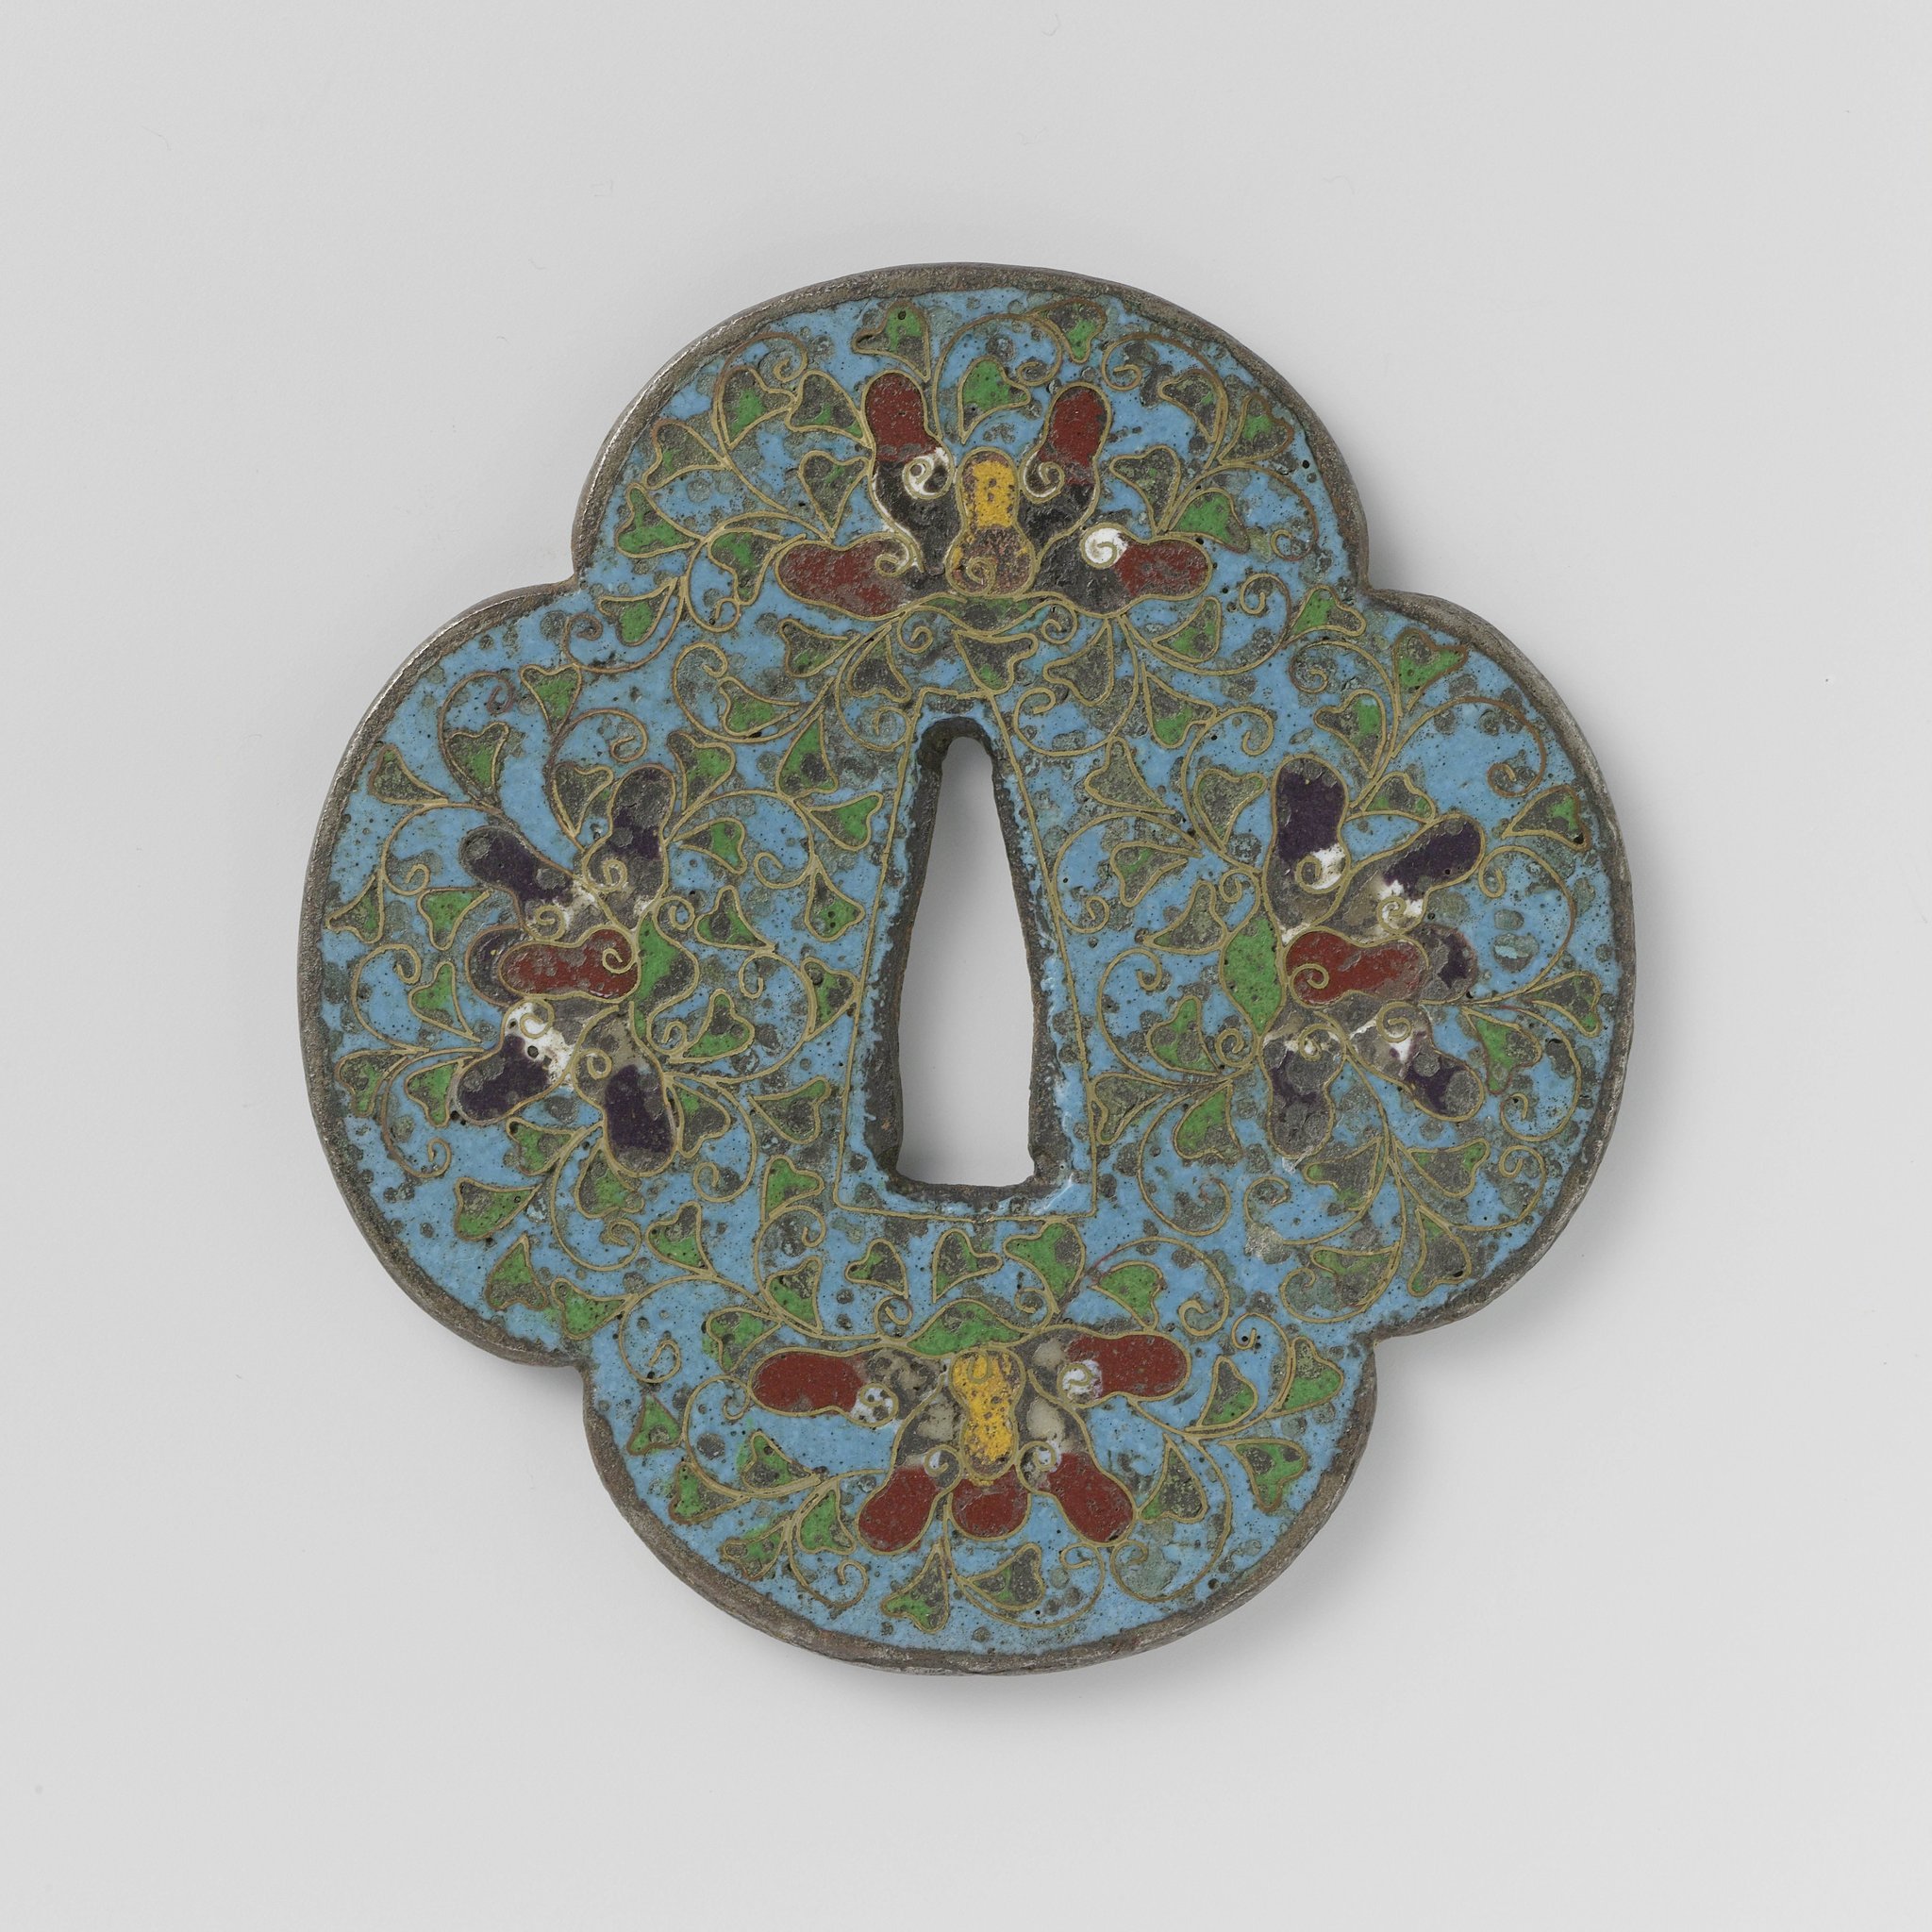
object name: tsuba, zwaardstootplaat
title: Hand guard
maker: Anonymous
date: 1600-1900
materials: copper, iron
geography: japan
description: Mokko-vormige tsuba met aan beide zijden gestileerde vlinders temidden van ranken in email cloisonné.